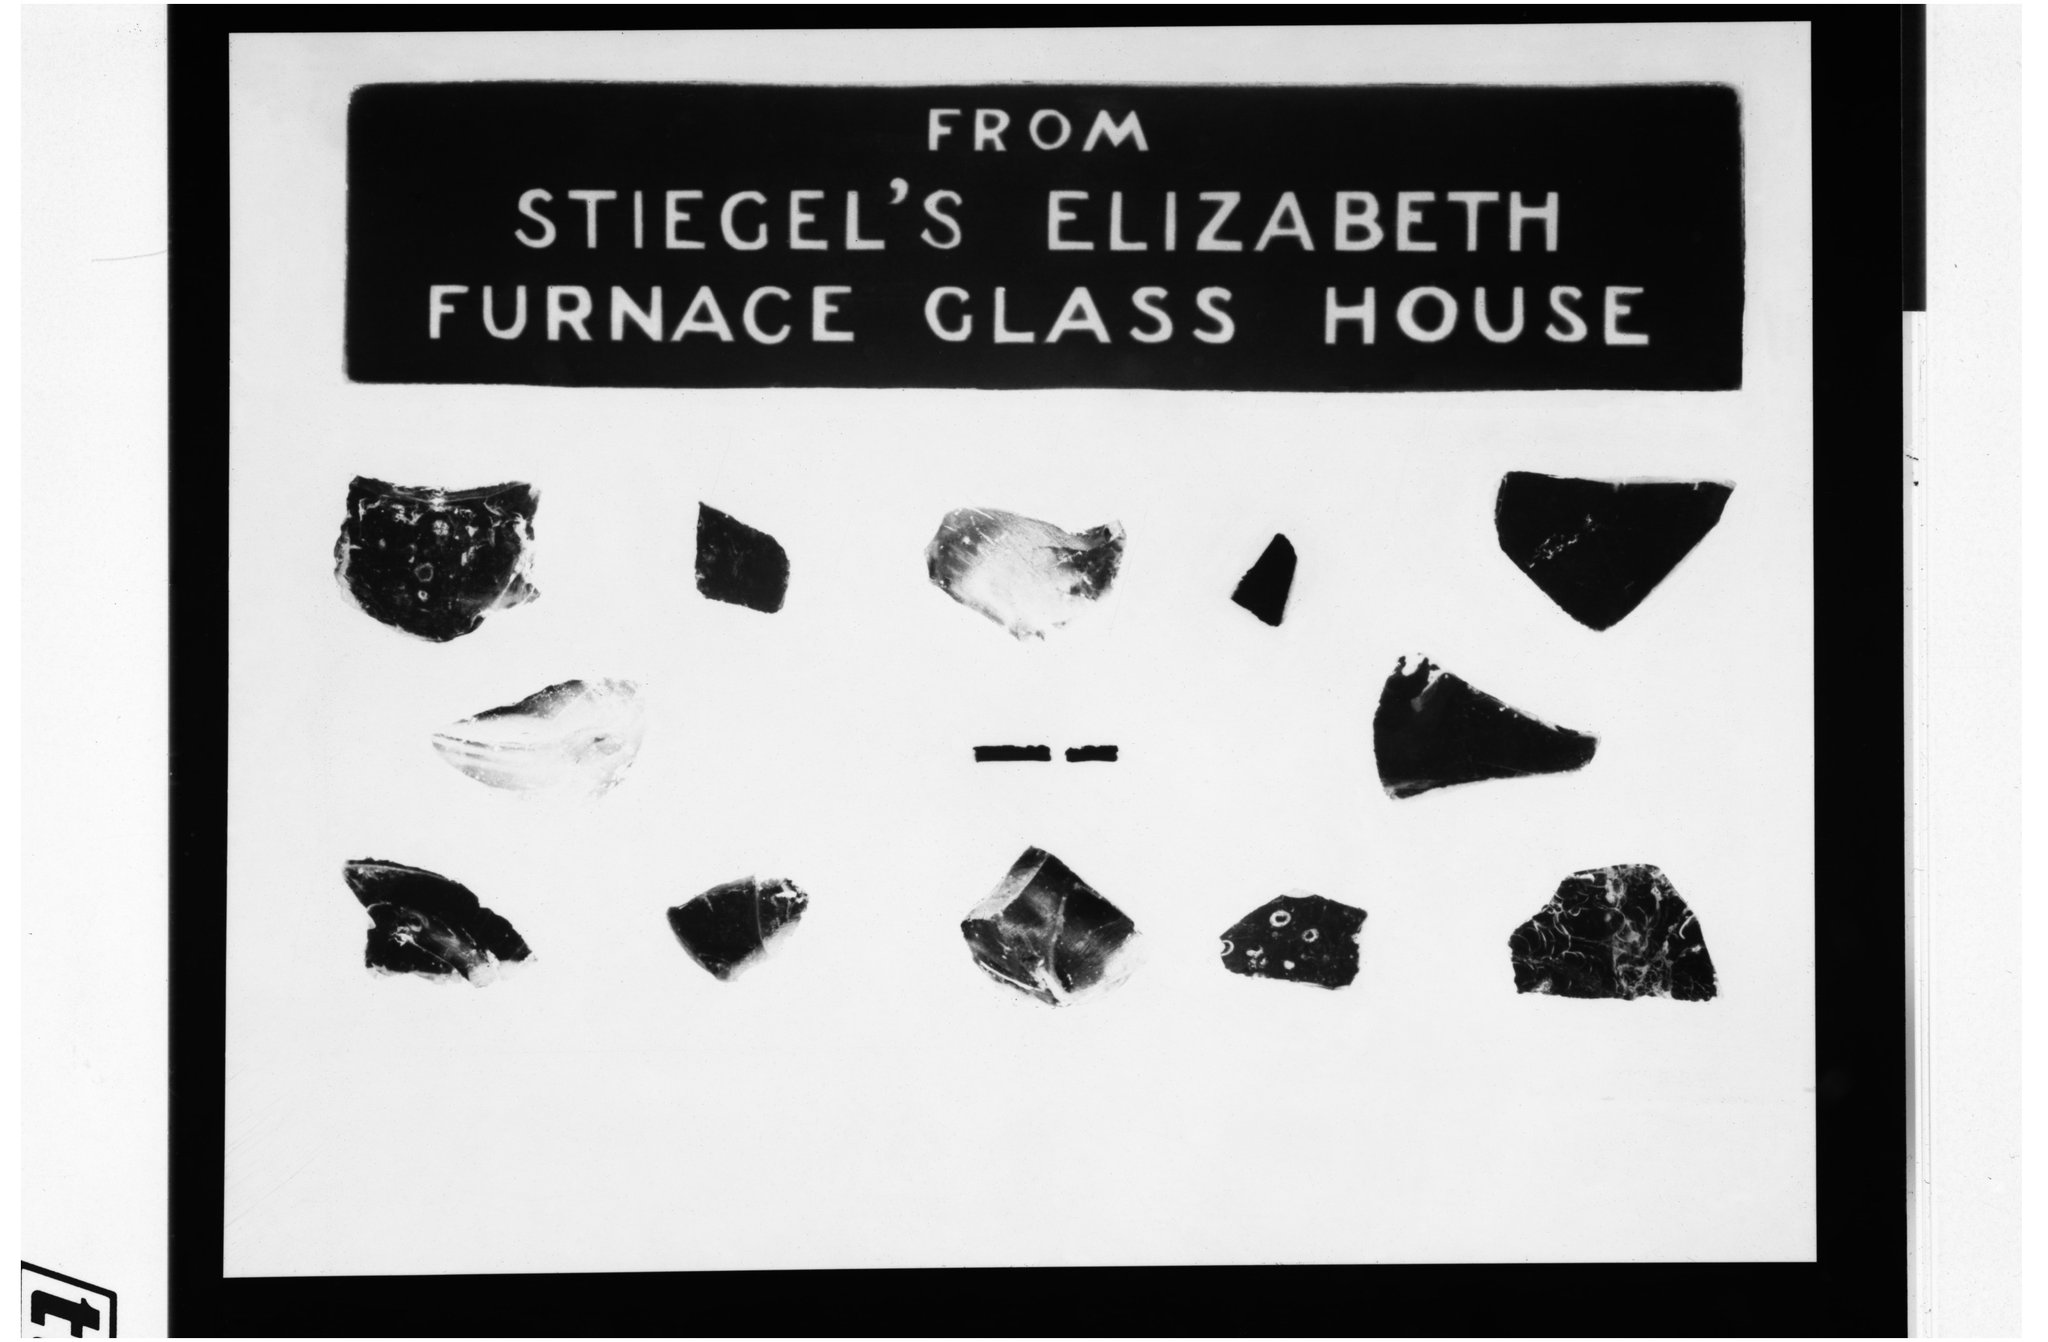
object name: glass panel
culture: american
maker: stiegel's elizabeth furnace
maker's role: maker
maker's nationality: american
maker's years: 1763-1774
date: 1763-1774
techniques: glassblowing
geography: united states